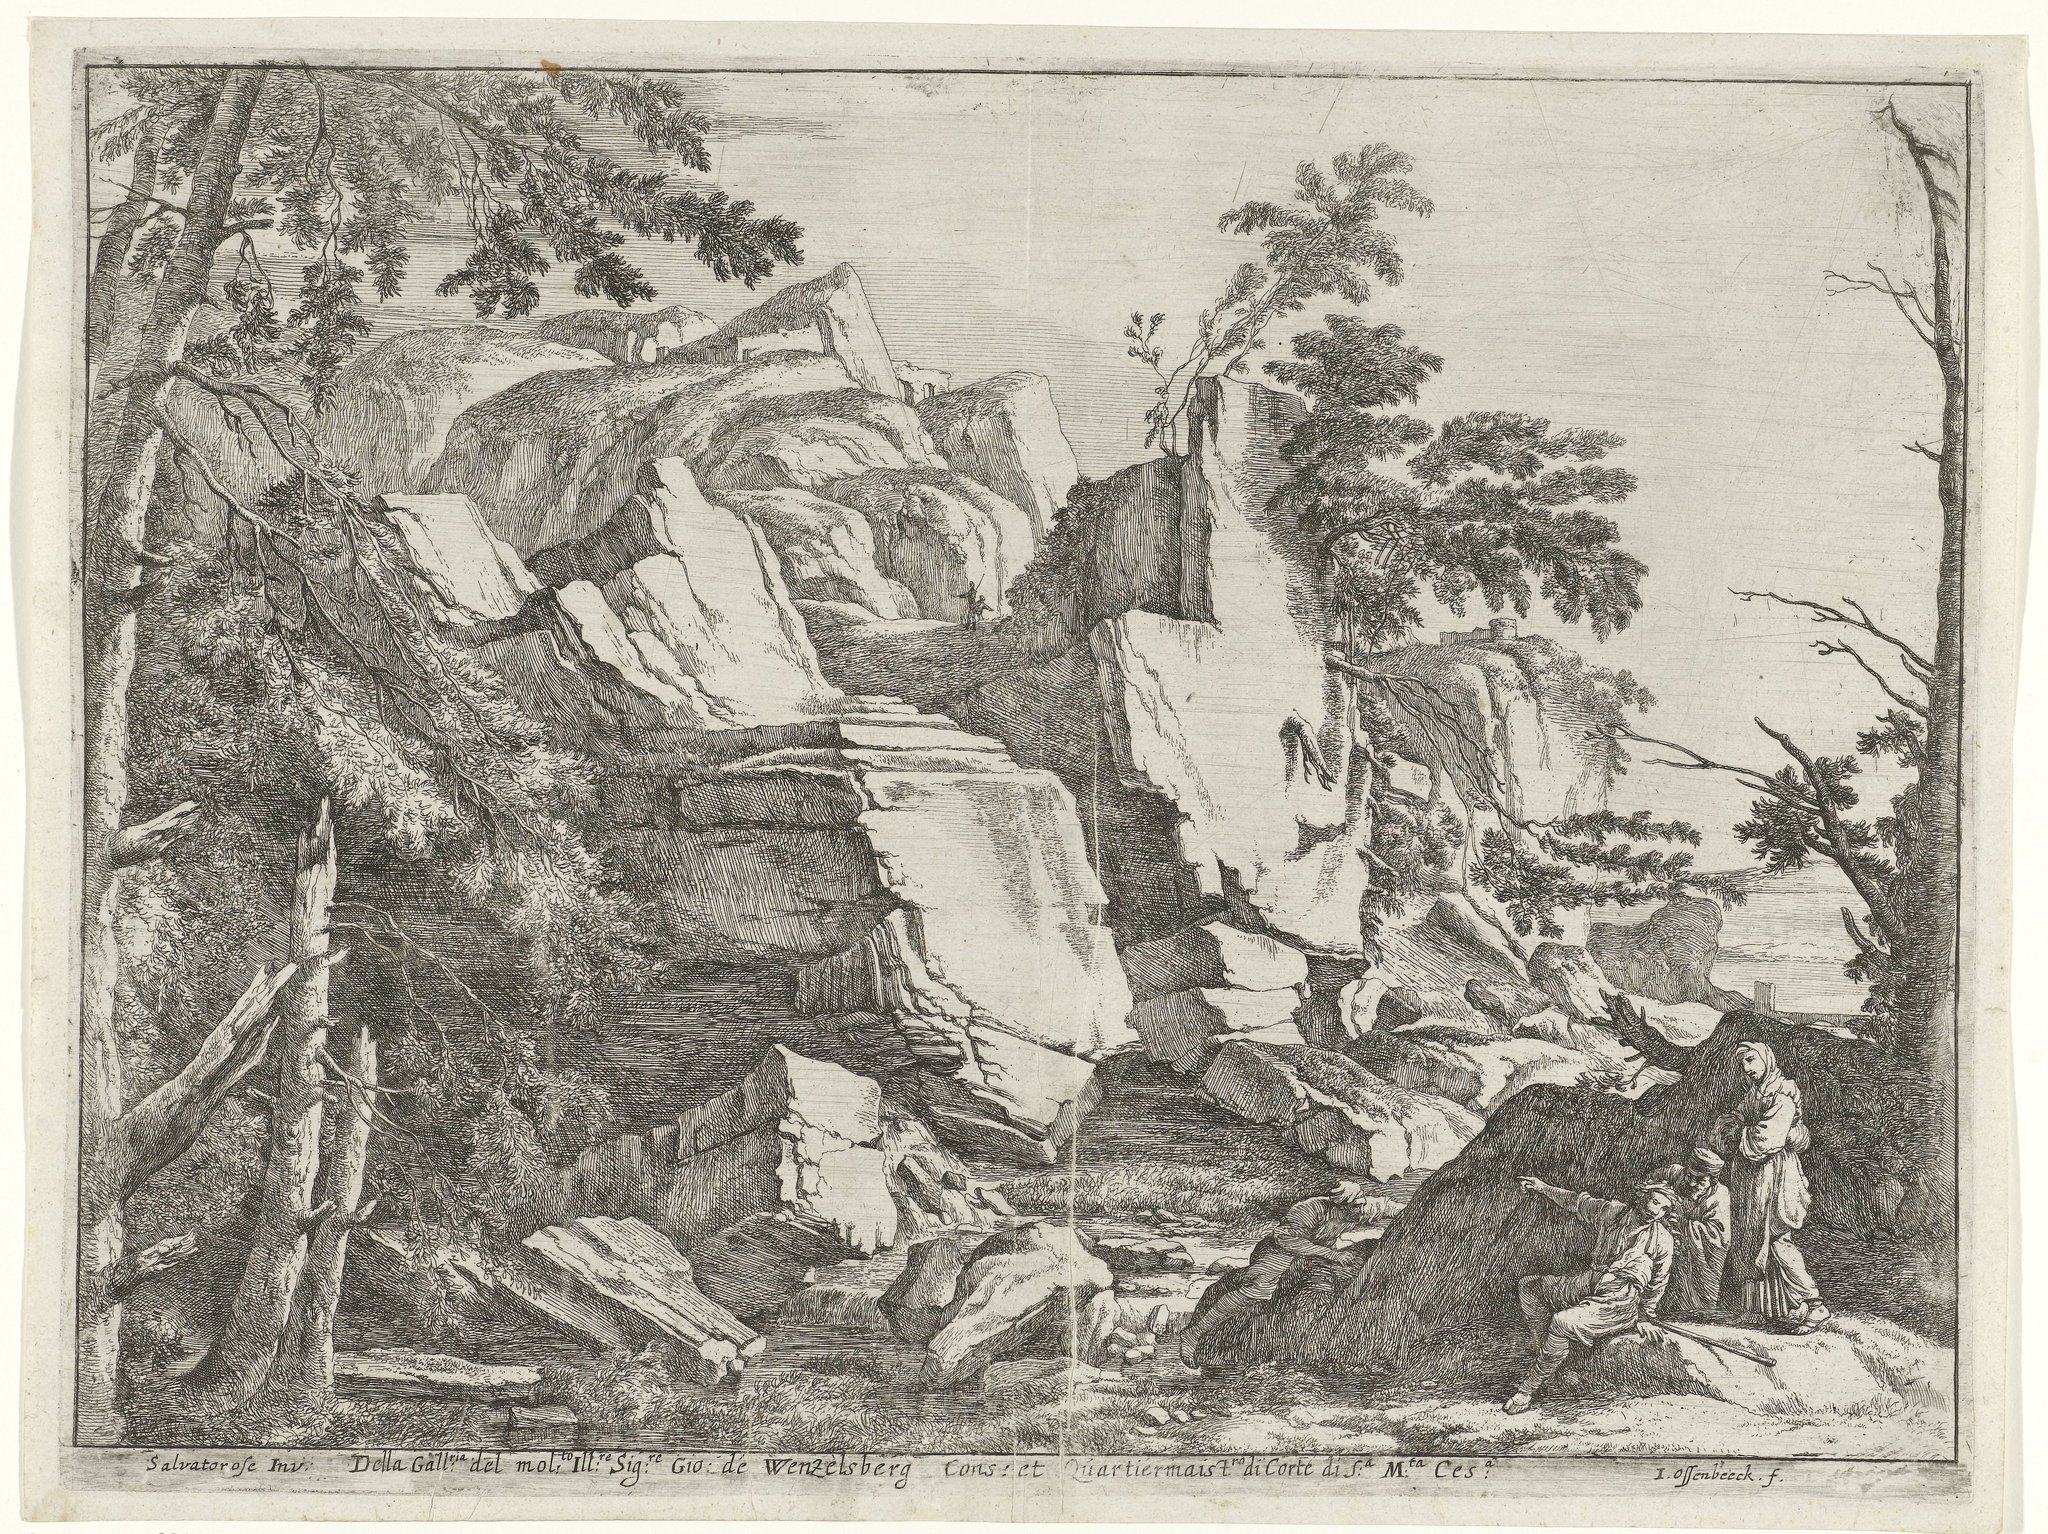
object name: print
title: Rotslandschap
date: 1663-1674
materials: paper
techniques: etching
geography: vienna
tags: rock-formations, asking the way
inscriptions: collector's mark: Lugt 240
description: Rotslandschap met rechts een doorkijk naar zee. Op de voorgrond vier mannen. Twee mannen vragen aan een rustende man de weg. Deze wijst iets in de verte aan. De vierde man klimt op een rots.